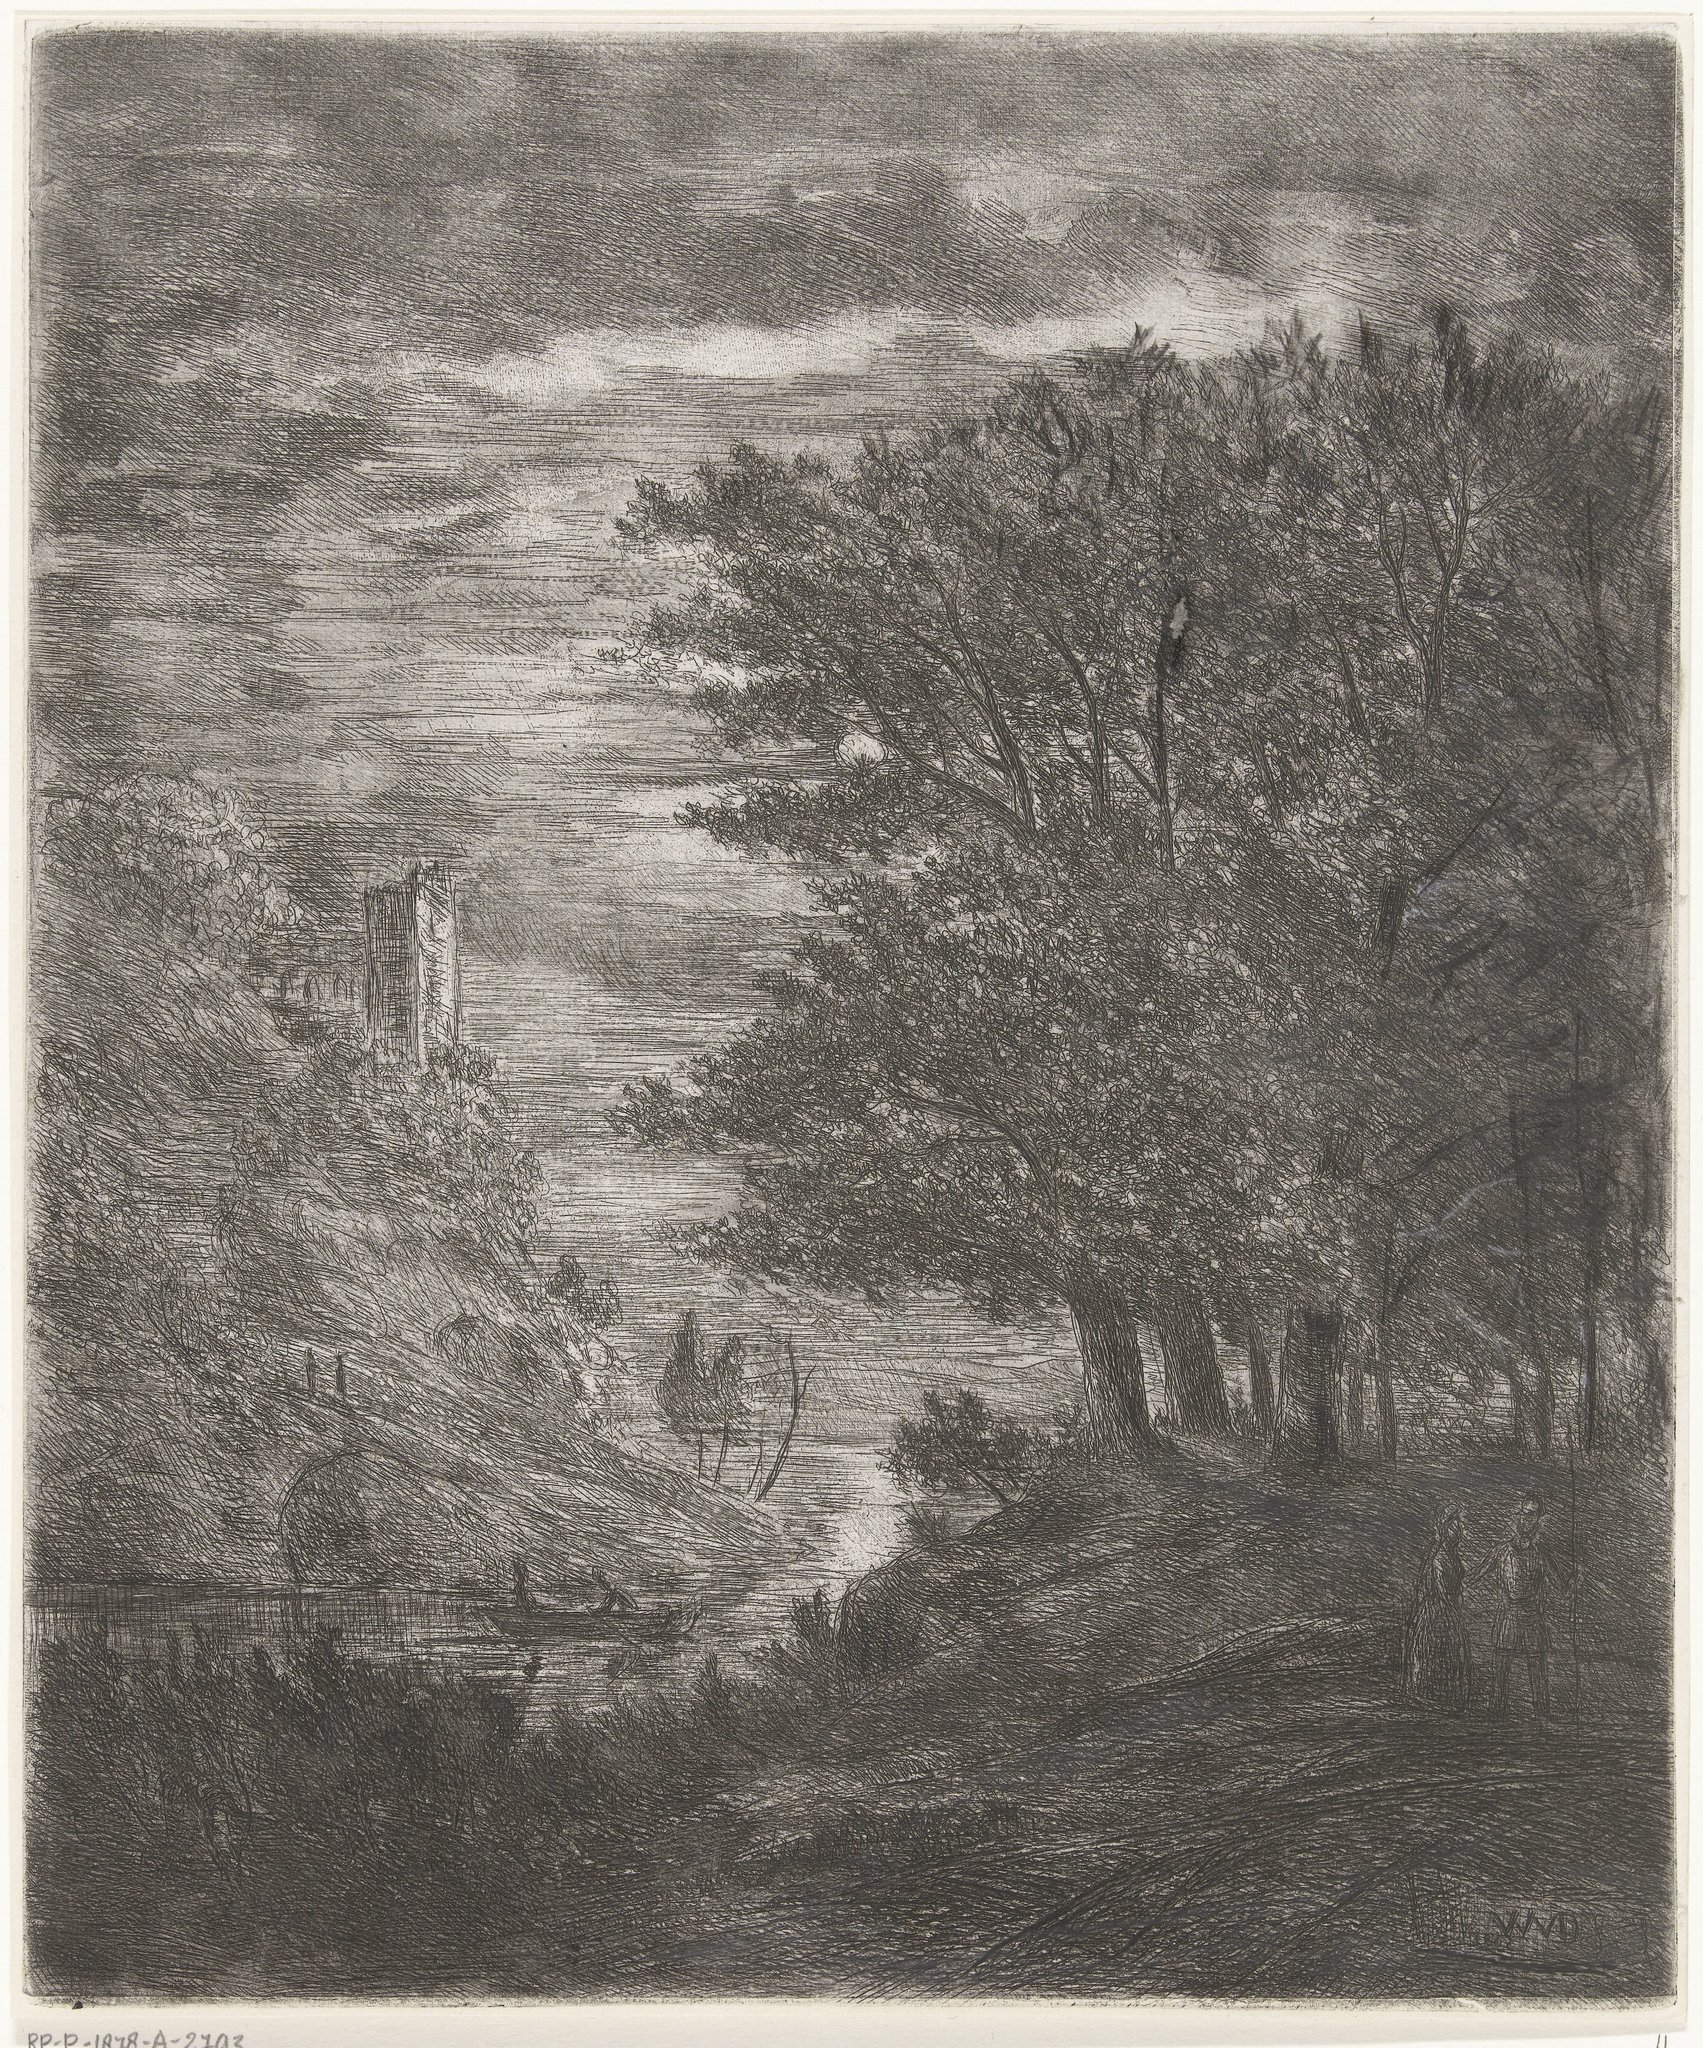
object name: print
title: Heuvellandschap met ruïne en bootje op water bij maanlicht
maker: willem matthias jan van dielen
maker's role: print maker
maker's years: 1805-1867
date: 1815-1867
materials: paper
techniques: aquatint, etching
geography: netherlands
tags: low hill country, moonlight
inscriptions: collector's mark: Lugt 2228